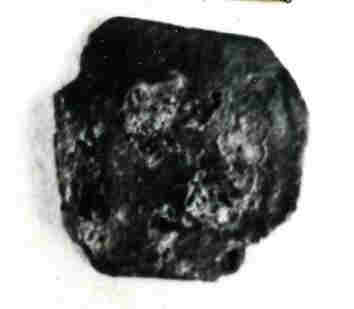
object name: coin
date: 701-900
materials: copper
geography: iran